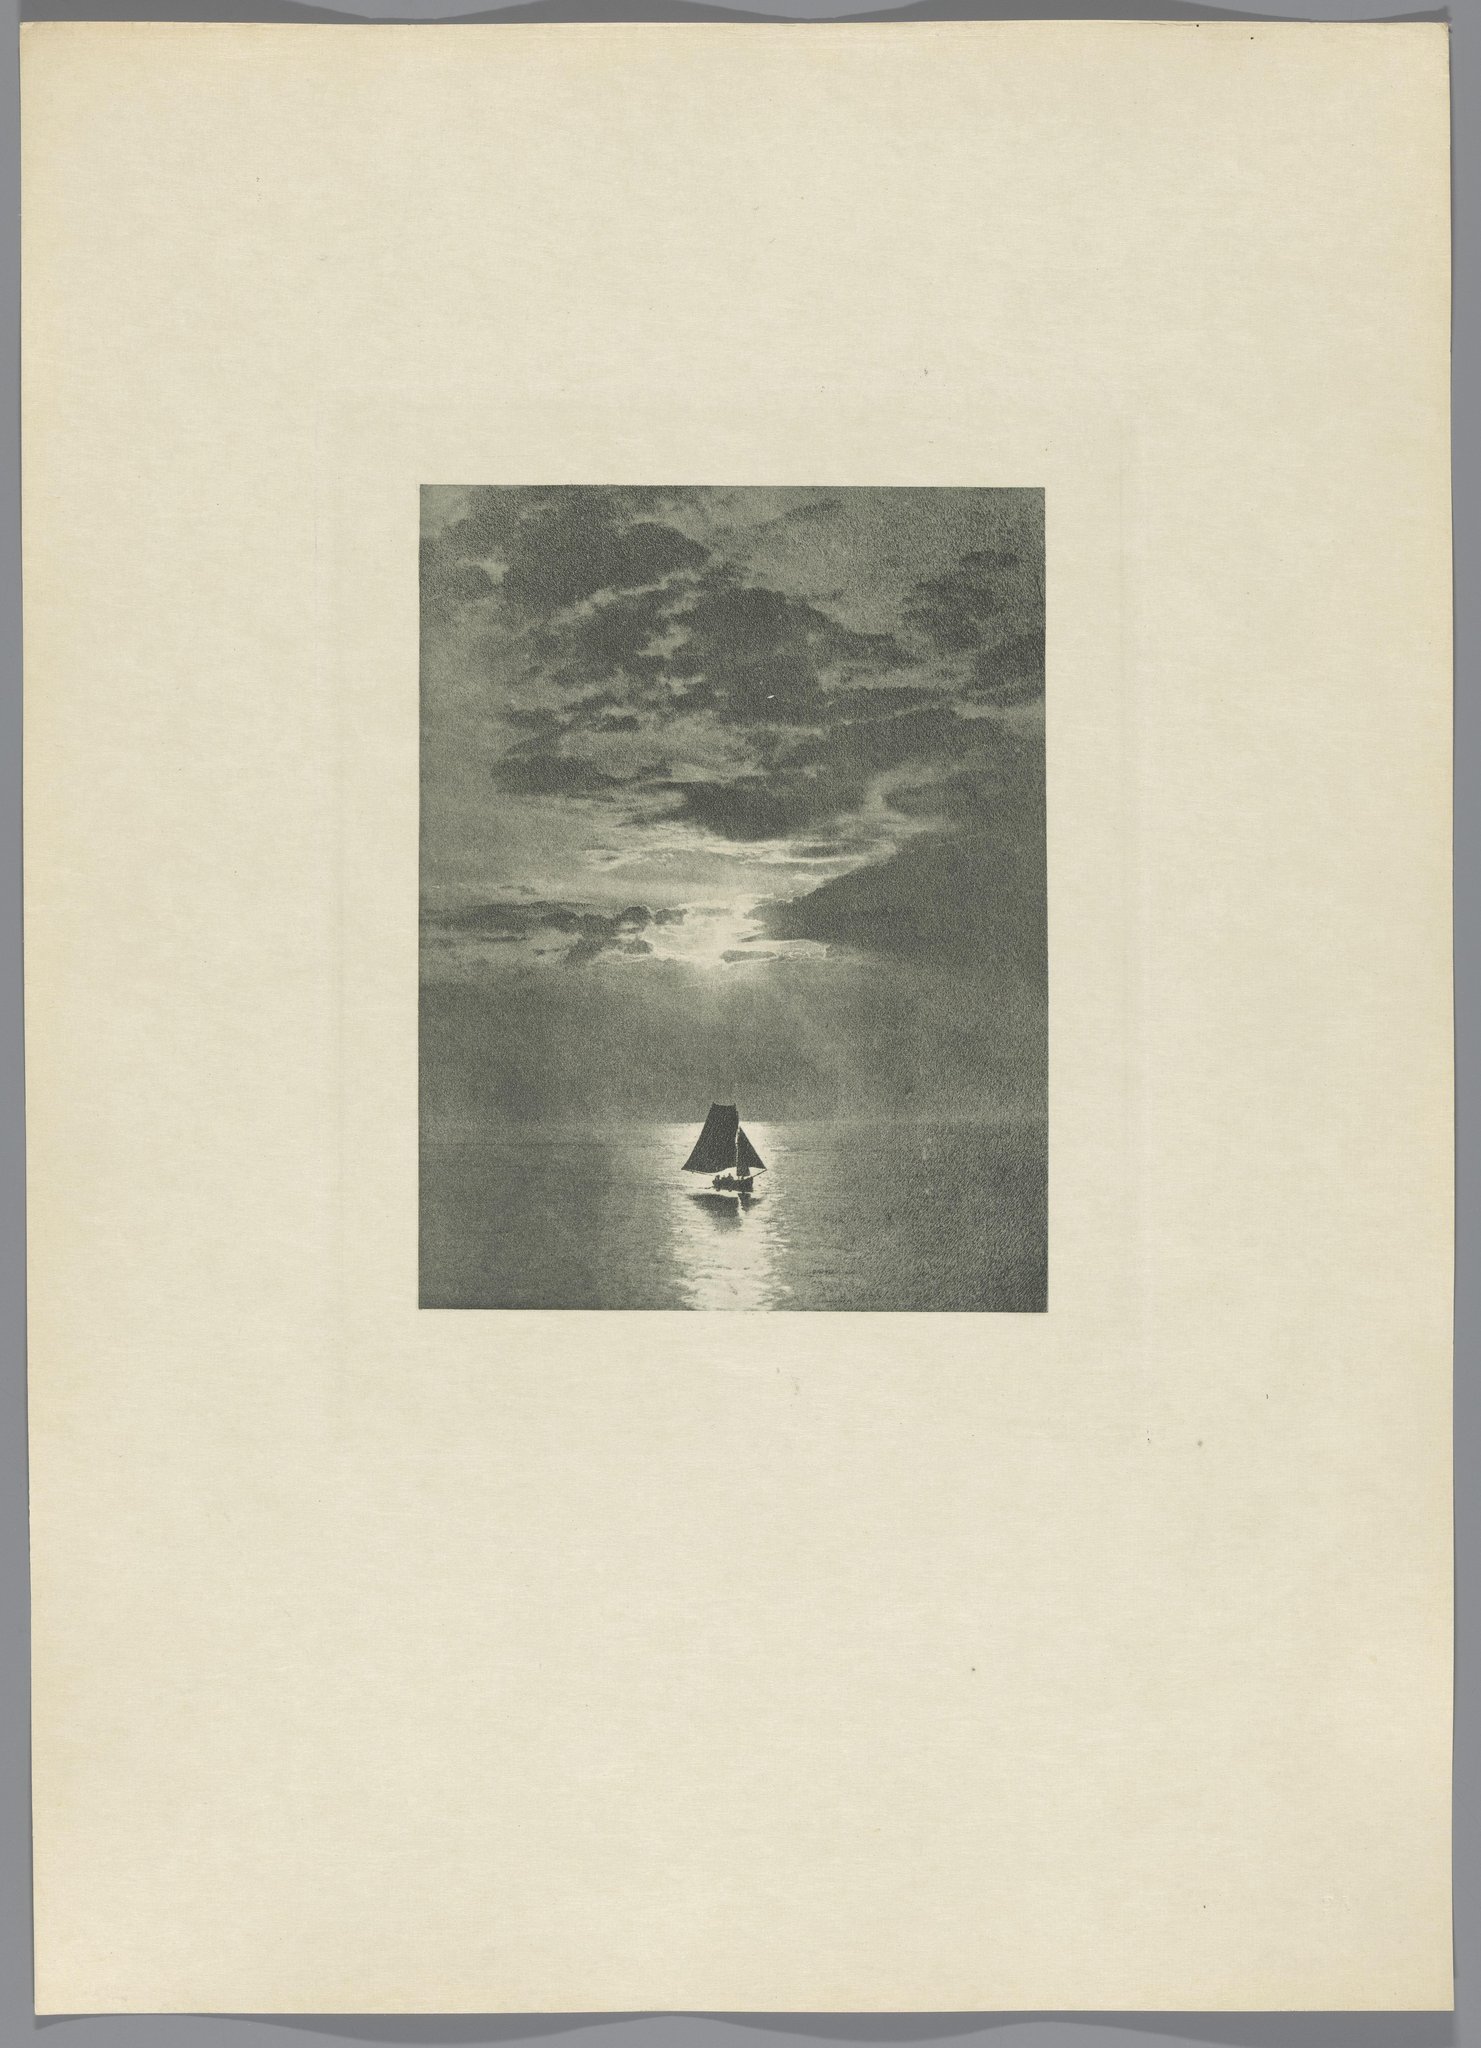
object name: photomechanical print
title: Zeegezicht bij maanlicht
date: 1891-1896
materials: paper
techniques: photoaquatint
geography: paris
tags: sailing-ship, sailing-boat, moonlight, sea (seascape)